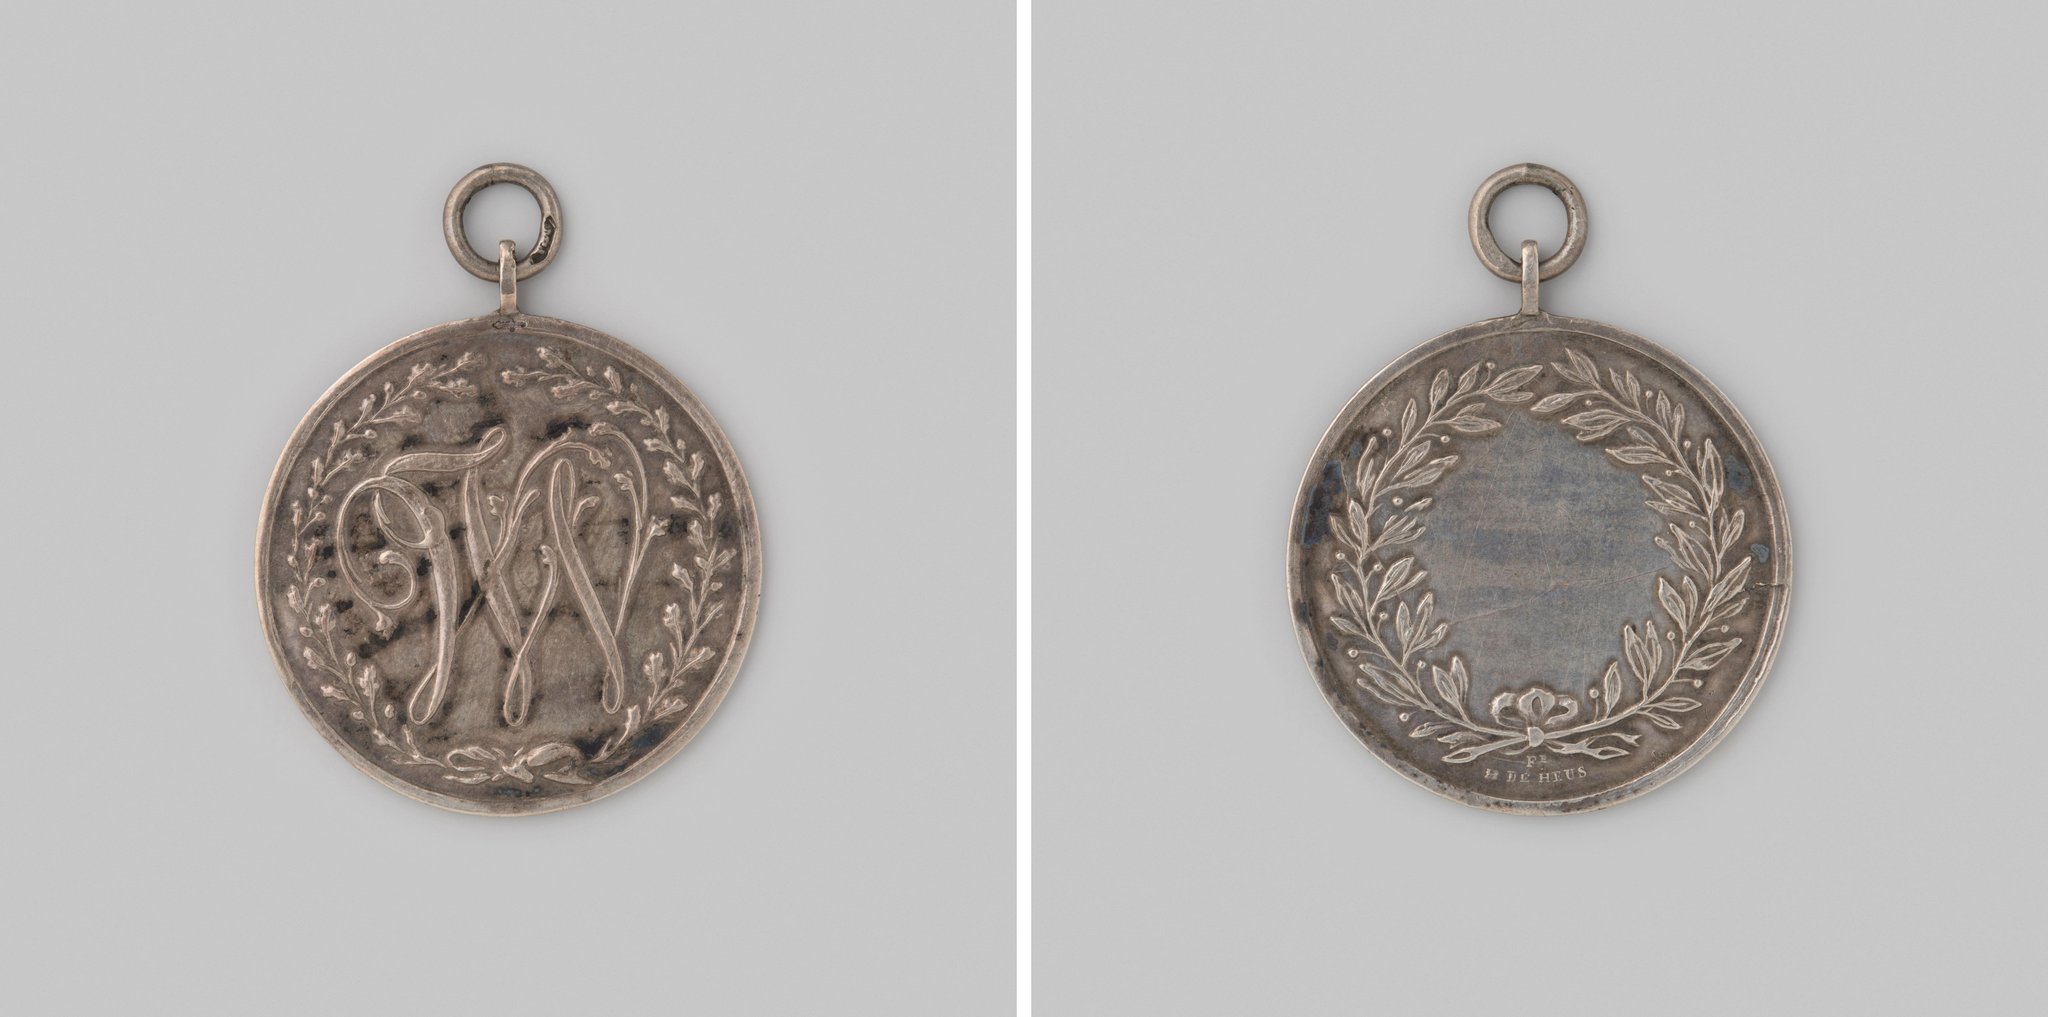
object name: draagpenning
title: Erepenning van de Vereeniging V.W. te Asterdam 1806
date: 1806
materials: silver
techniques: striking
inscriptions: hallmark, inscription: ‘VW’, hallmark: ‘(zwaardje)’, signature: ‘Fb. / H. DE HEUS’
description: Zilveren penning, op de voorzijde de verweven letters VW tussen samengestrikte eikentakken, op de keerzijde een inscriptieruimte tussen samengestrikte eikentakken, met oog en draagring.